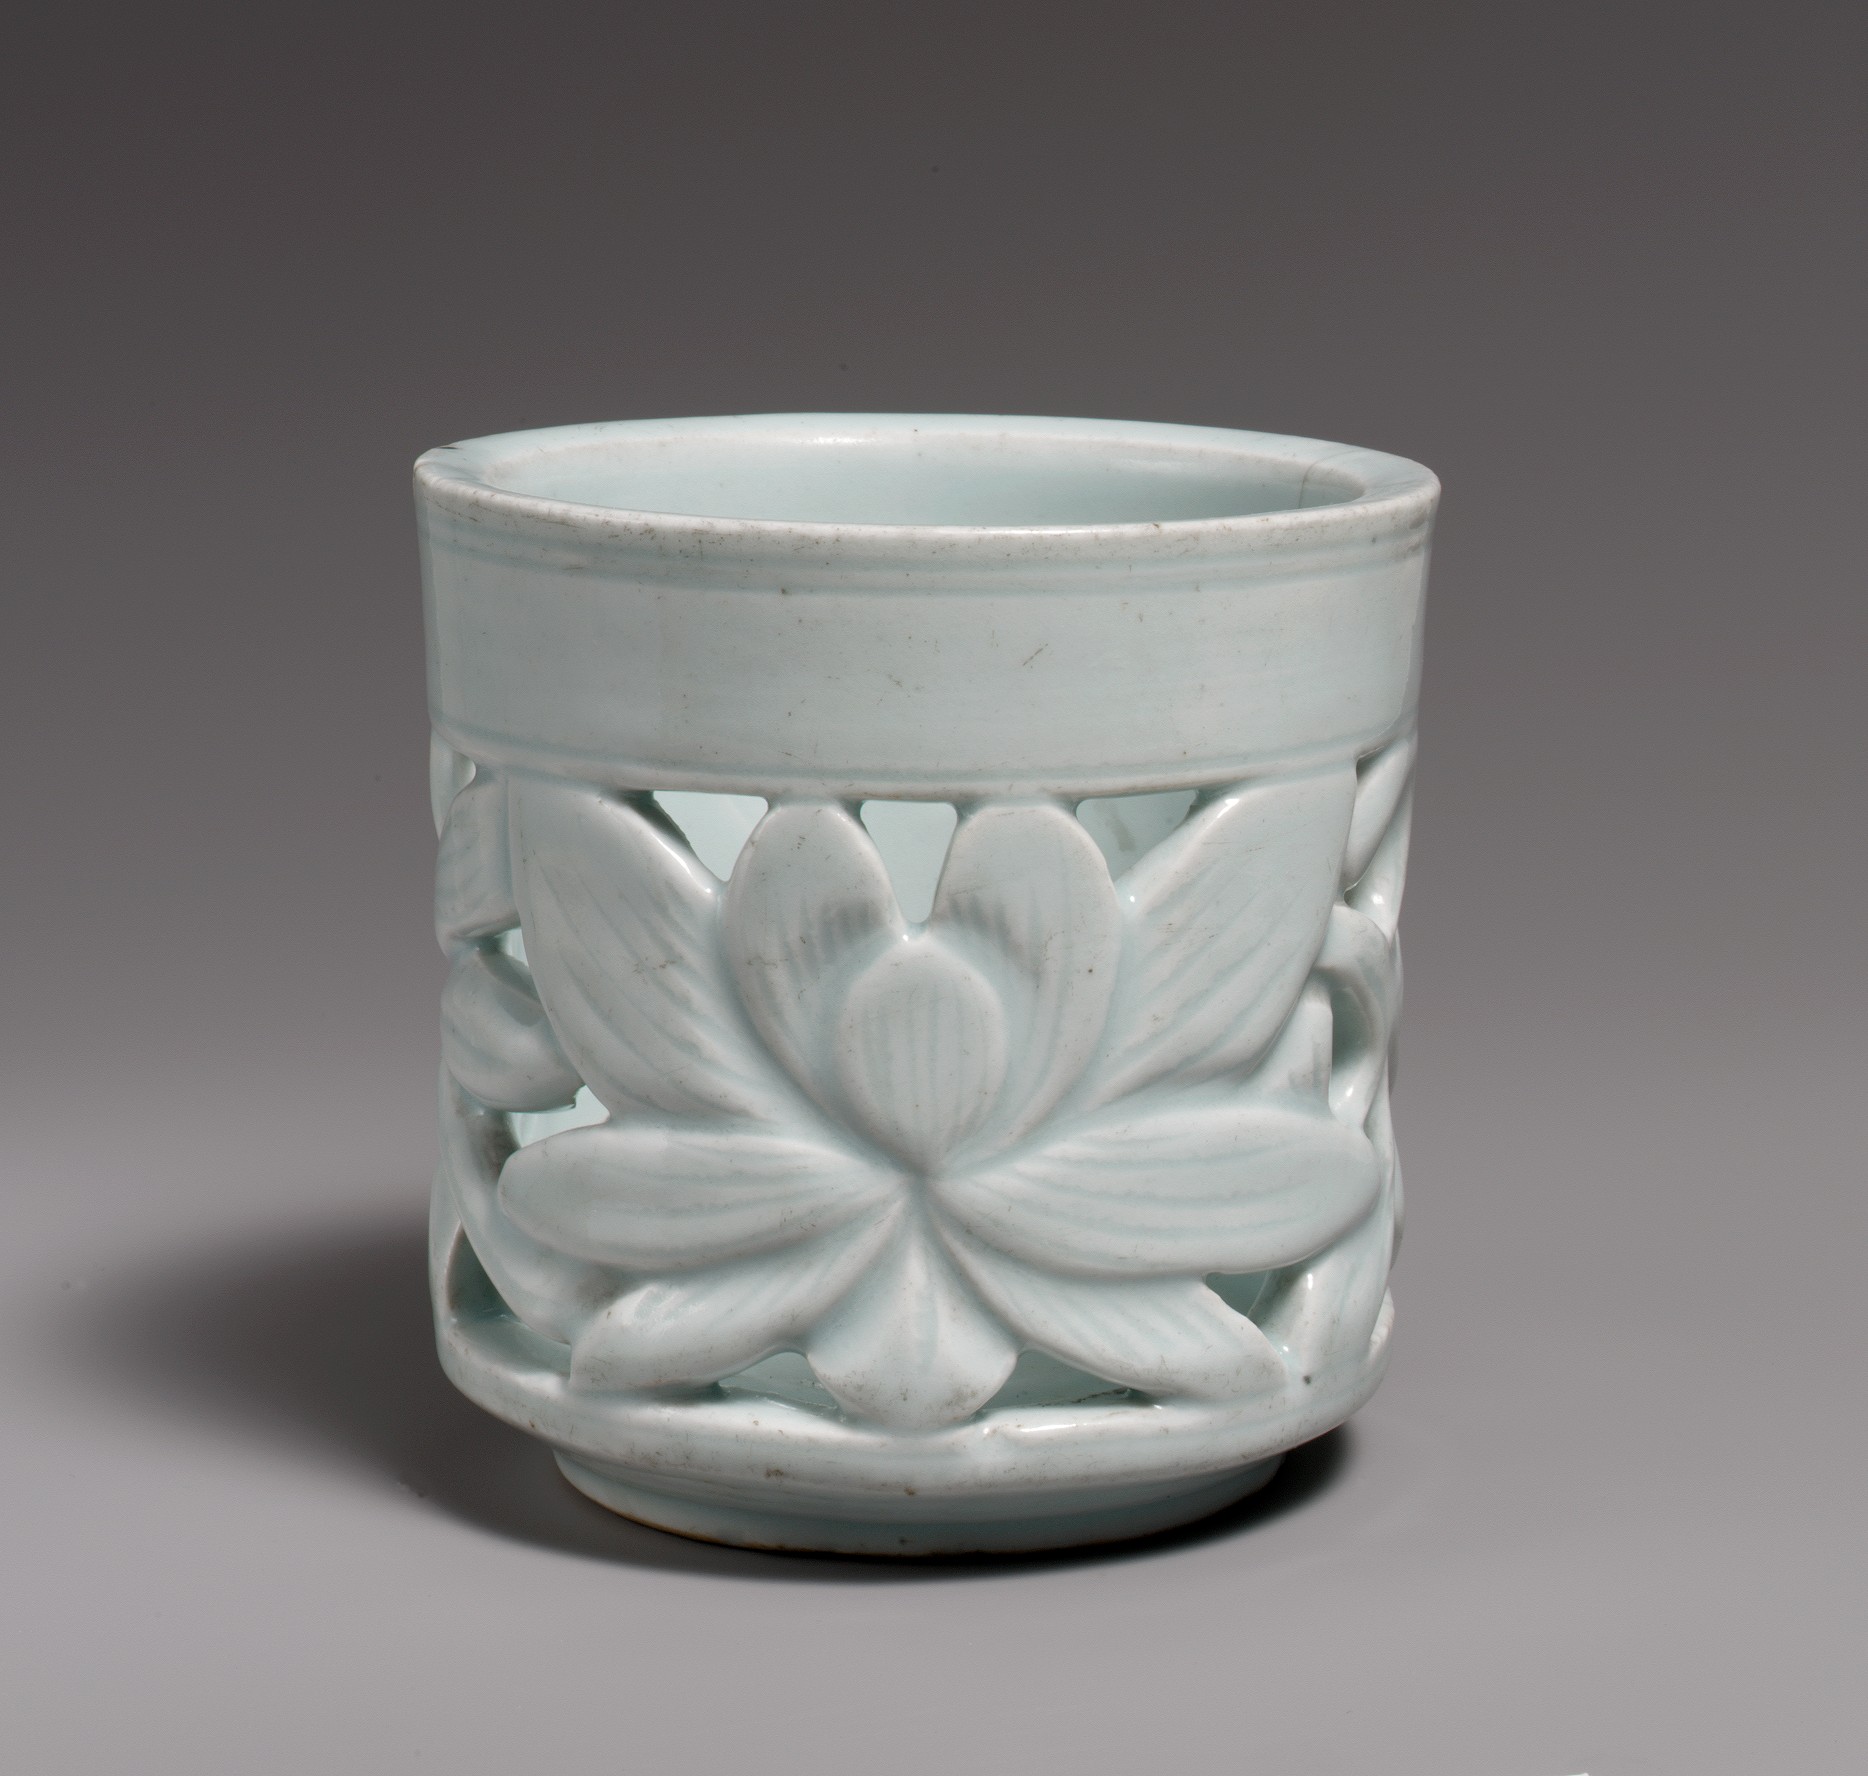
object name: brush holder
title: Brush holder with lotus decoration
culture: korean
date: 1834-1866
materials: porcelain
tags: lotuses